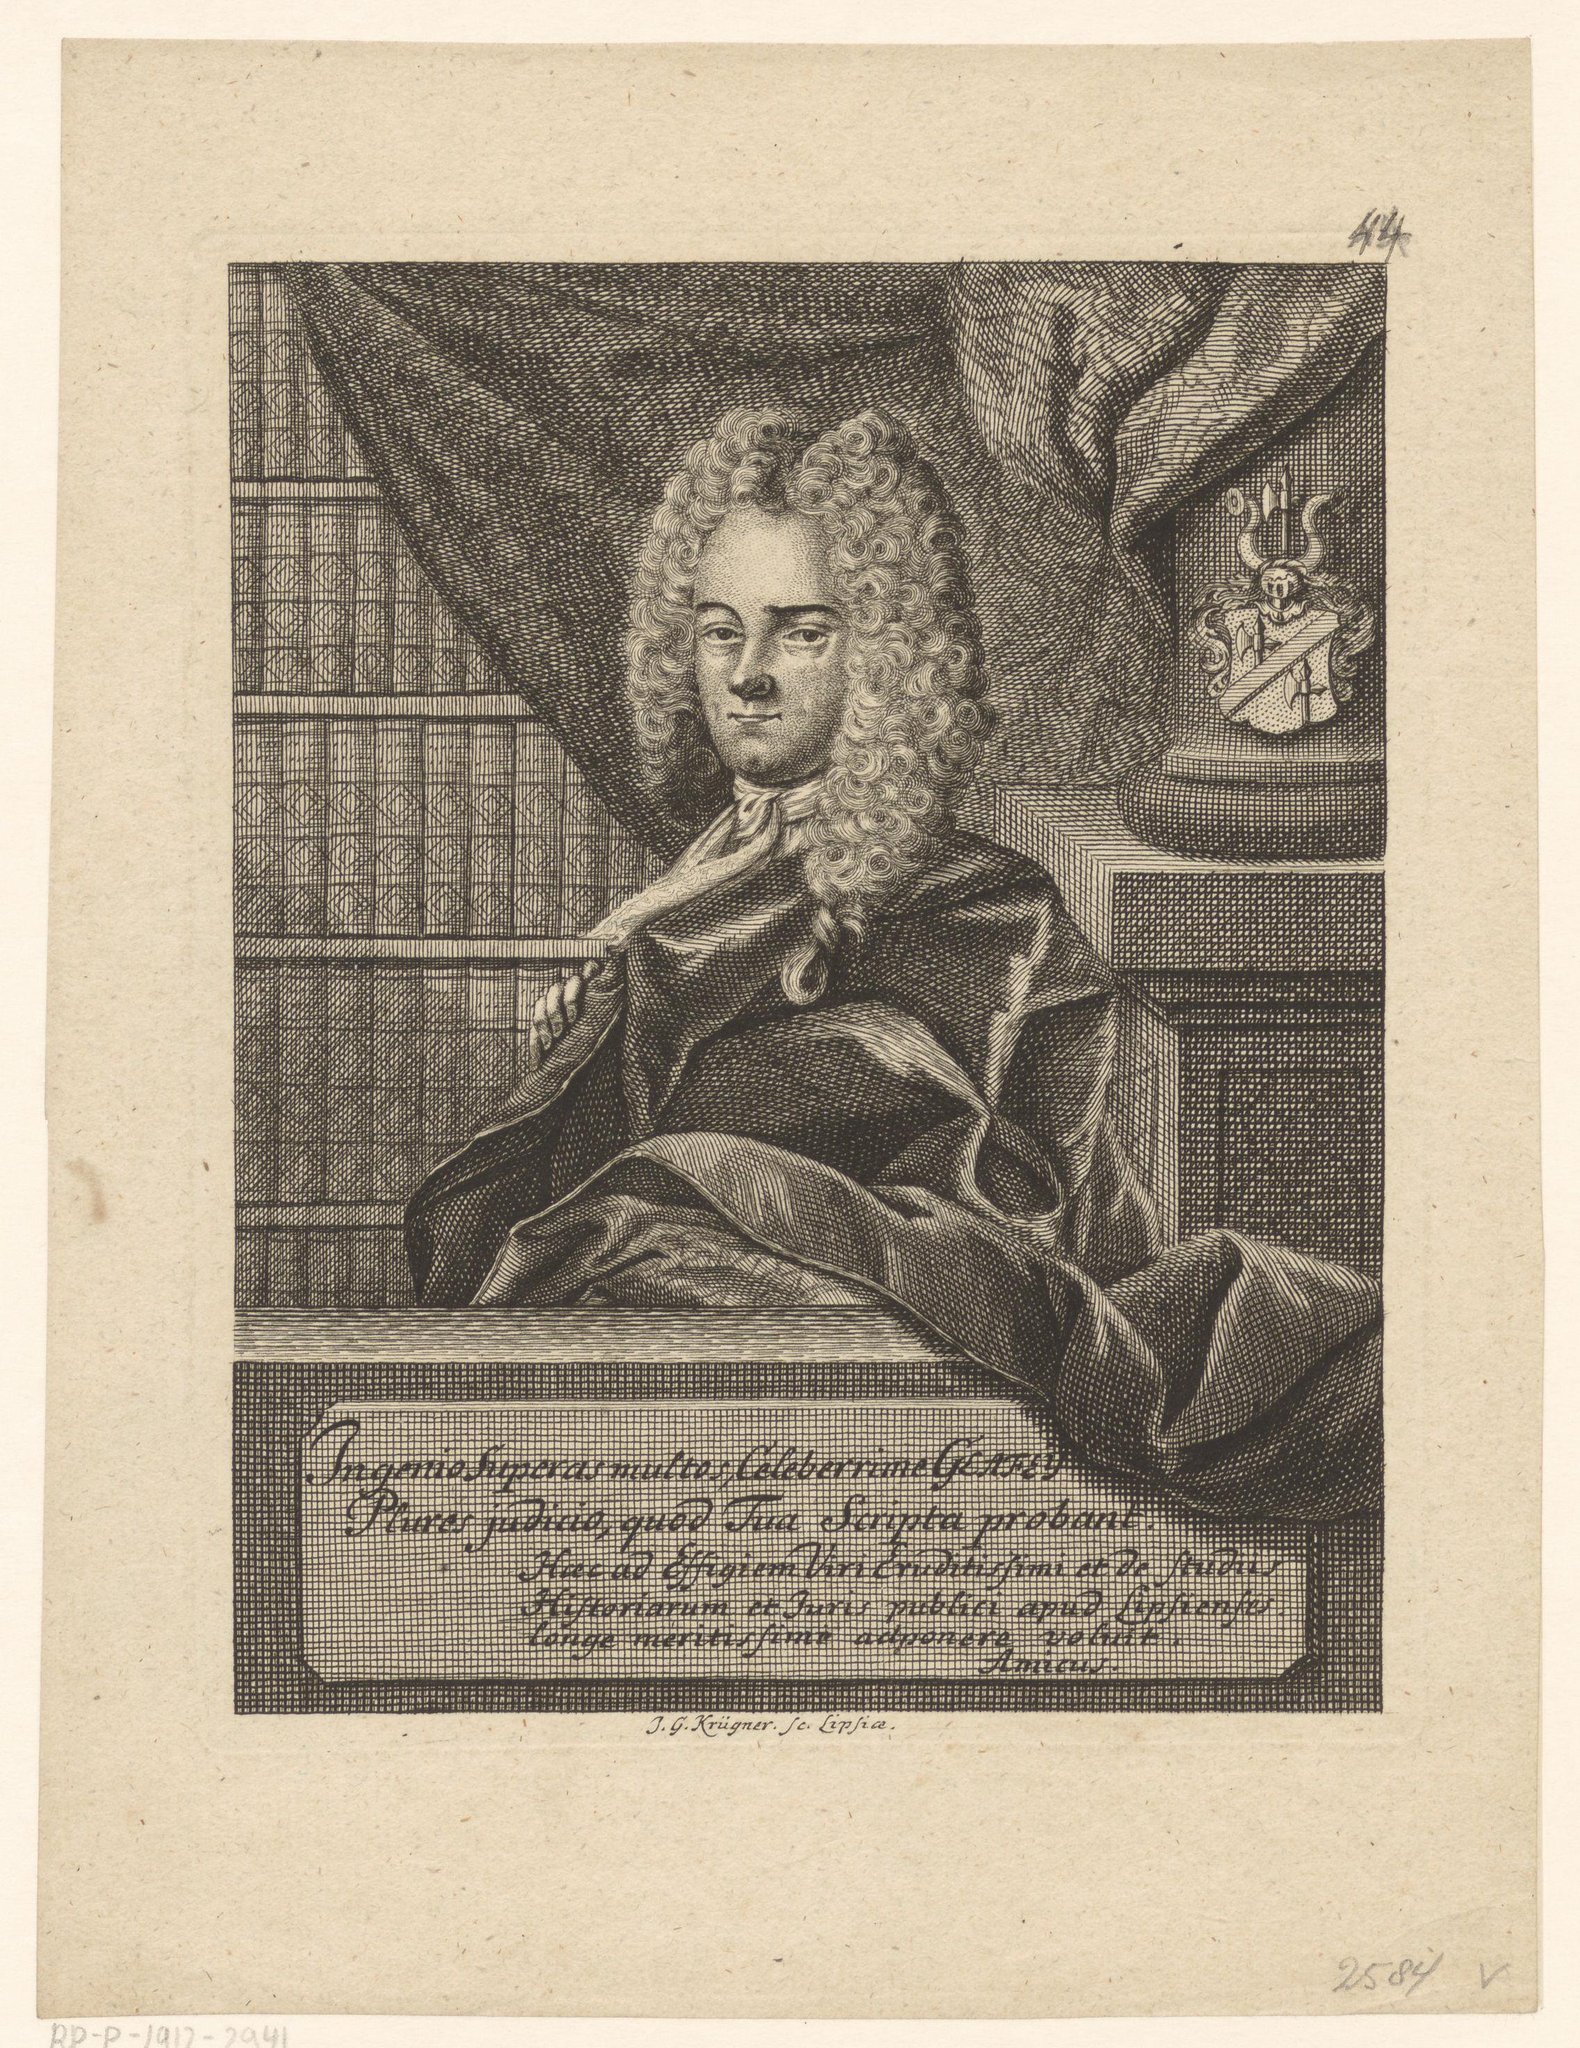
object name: print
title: Portret van Adam Friedrich Glafey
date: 1722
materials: paper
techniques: engraving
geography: nuremberg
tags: historical persons, scholar, philosopher (+ portrait of scholar, scientist)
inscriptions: collector's mark: Lugt 2228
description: Prent uit: Glafey, Adam Friedrich. Historia Germaniae Polemica (...). Leipzig: Christoph Riegel, 1722, tegenover de titelpagina.